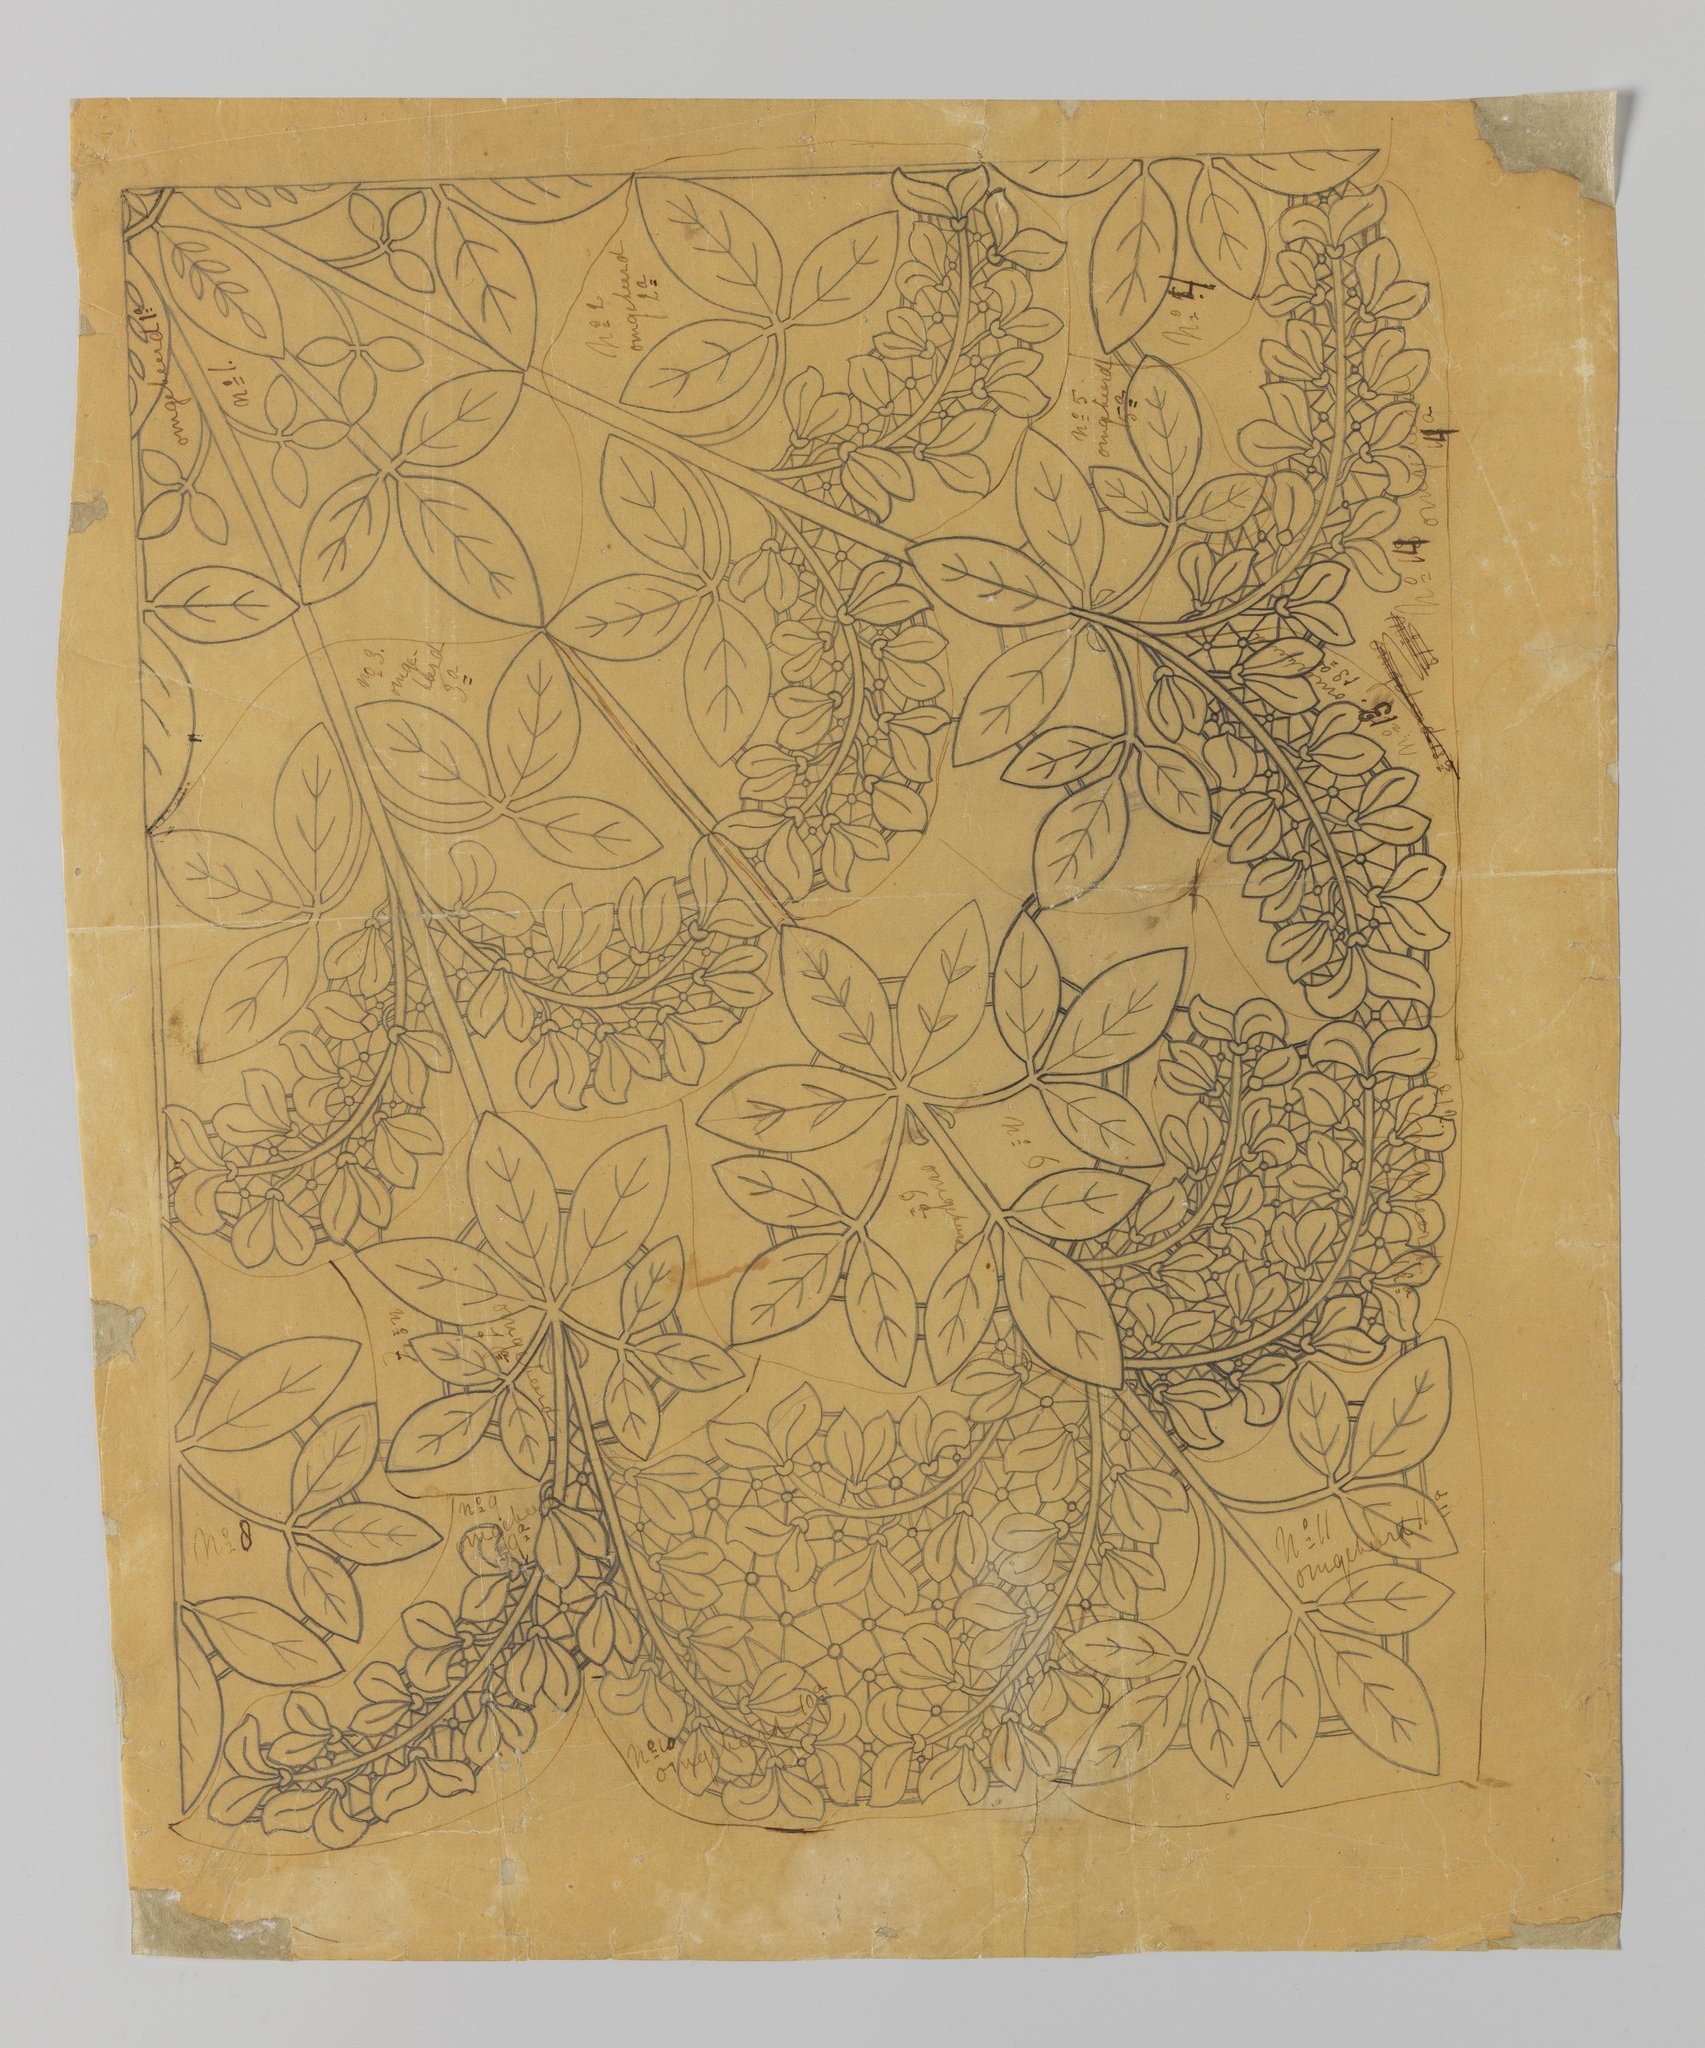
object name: design drawing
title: Ontwerptekening op calqueerpapier voor een kleed van kloskant met goudenregentakken en -bloemen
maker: louise wilhelmina van der meulen-nulle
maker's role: docent, kantwerkster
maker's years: 1884-1982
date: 1912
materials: ink, paper, pencil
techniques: drawing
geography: apeldoorn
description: Ontwerptekening op calqueerpapier voor een kleed van kloskant: duchesse-kant. Het ontwerp met goudenregenmotief is gemaakt door mevrouw Van der Meulen-Nulle. Zie ook de bijbehorende prikpatronen en het gekloste kleed, uitgevoerd door mevrouw Bloemink-van Baeren.